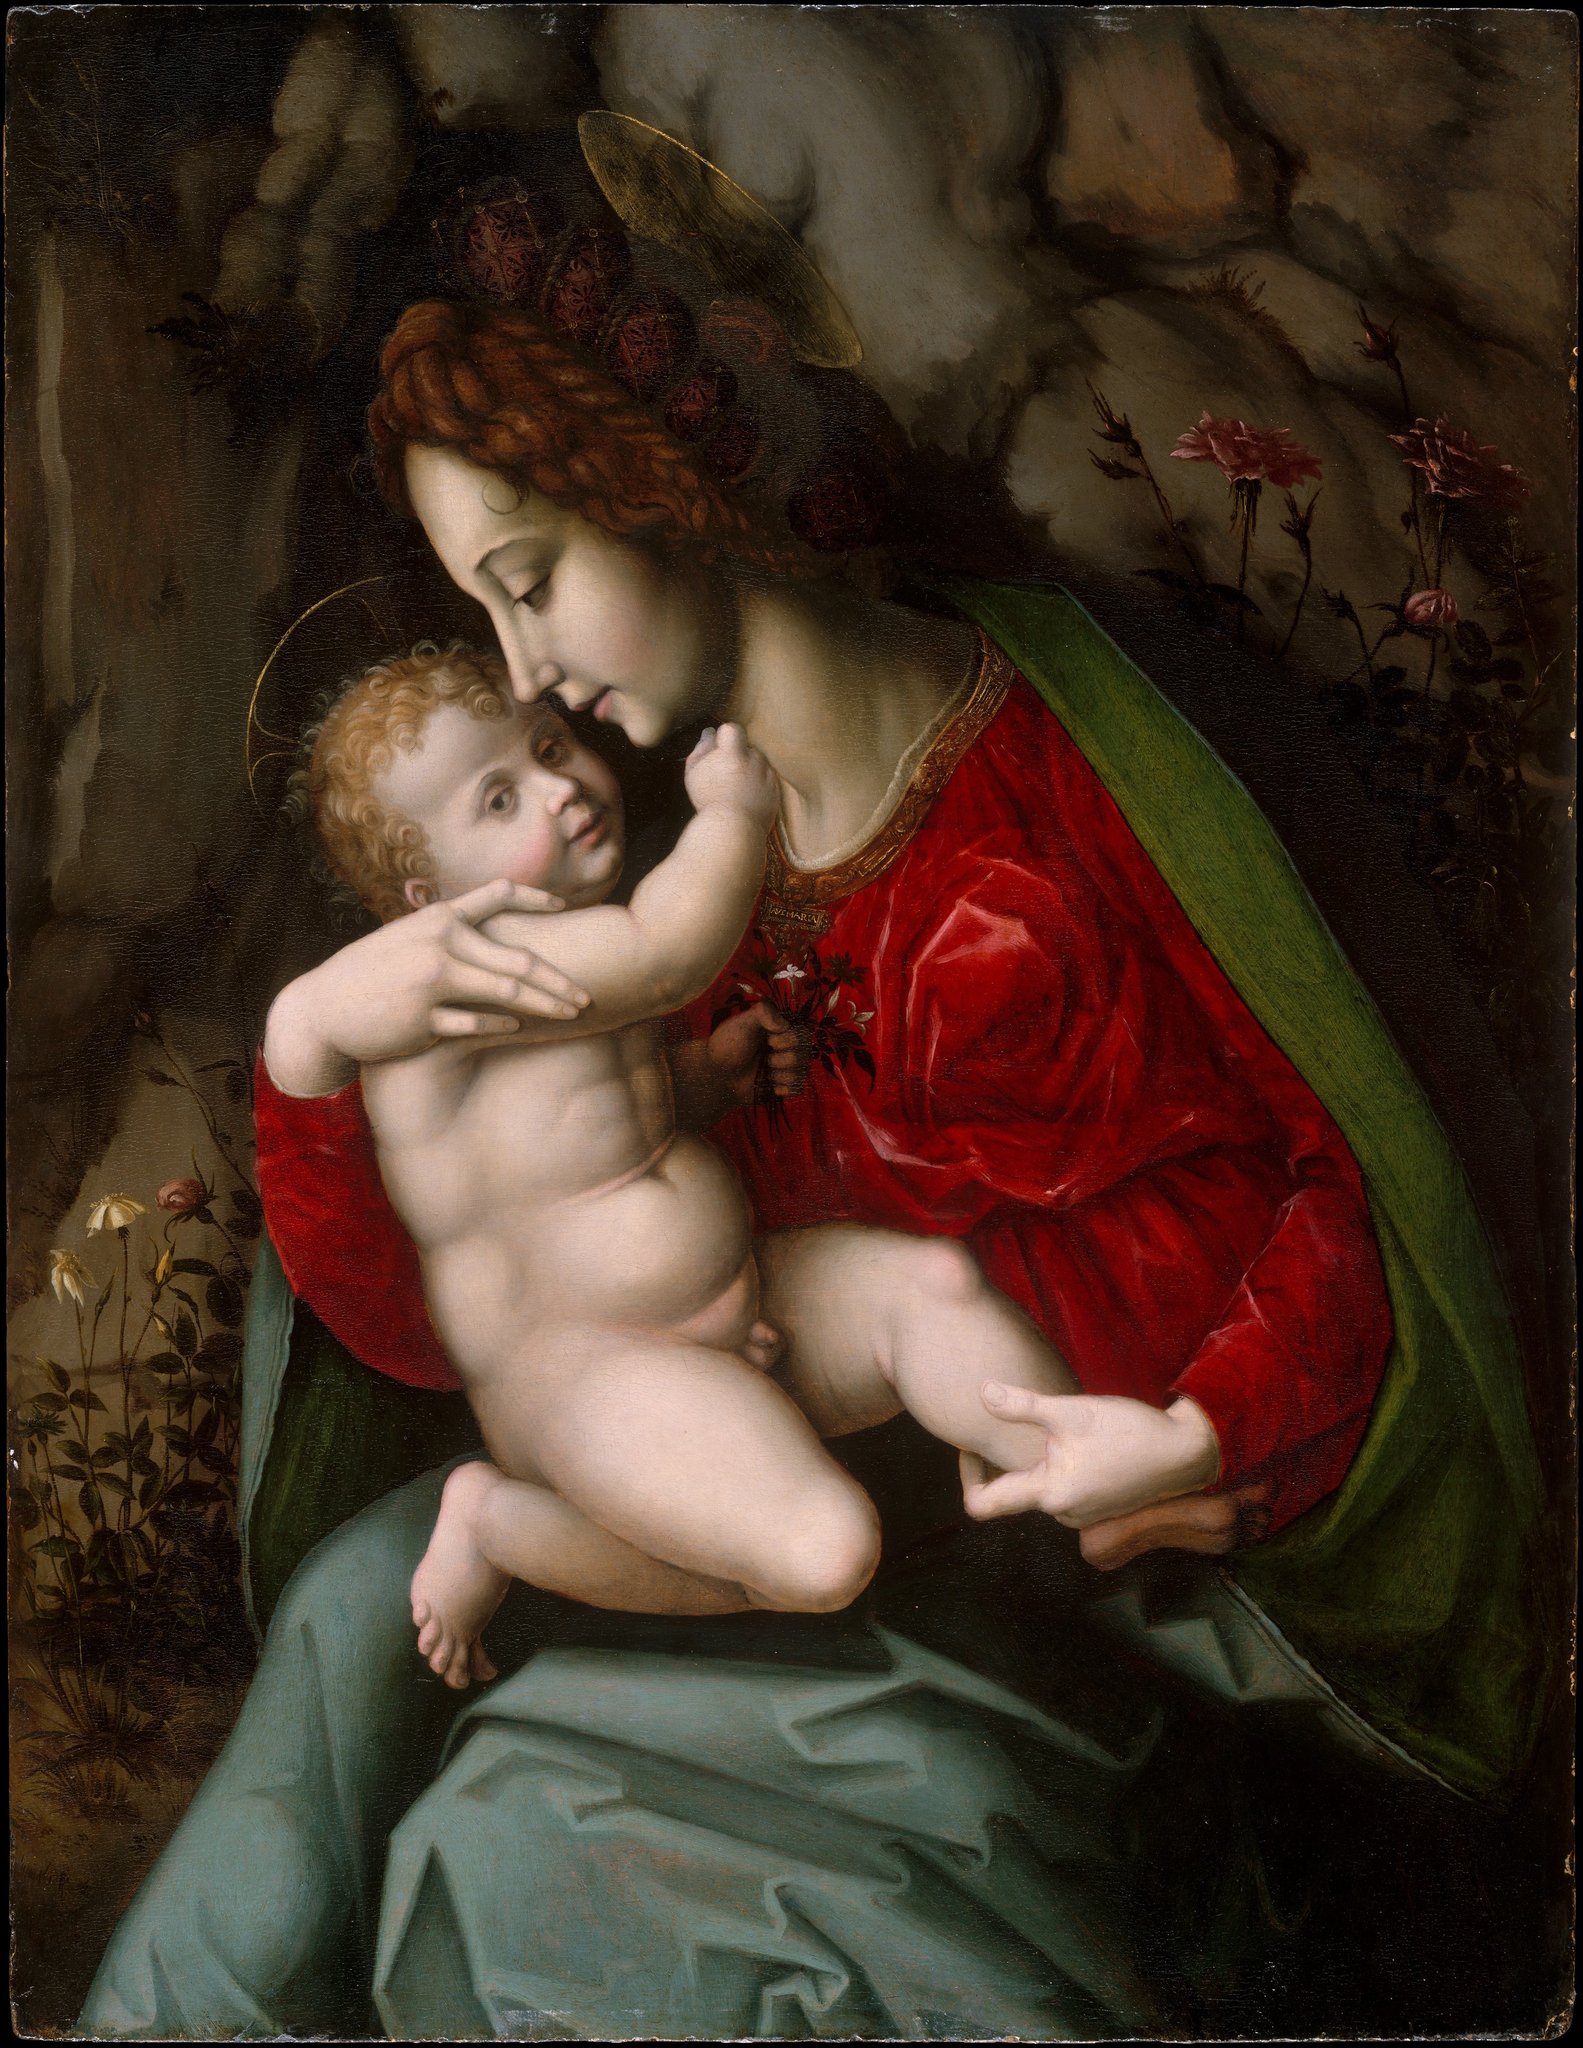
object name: painting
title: Madonna and Child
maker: bachiacca (francesco d'ubertino verdi)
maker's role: artist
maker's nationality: italian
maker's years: 1494-1557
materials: gold, oil, wood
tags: madonna and child